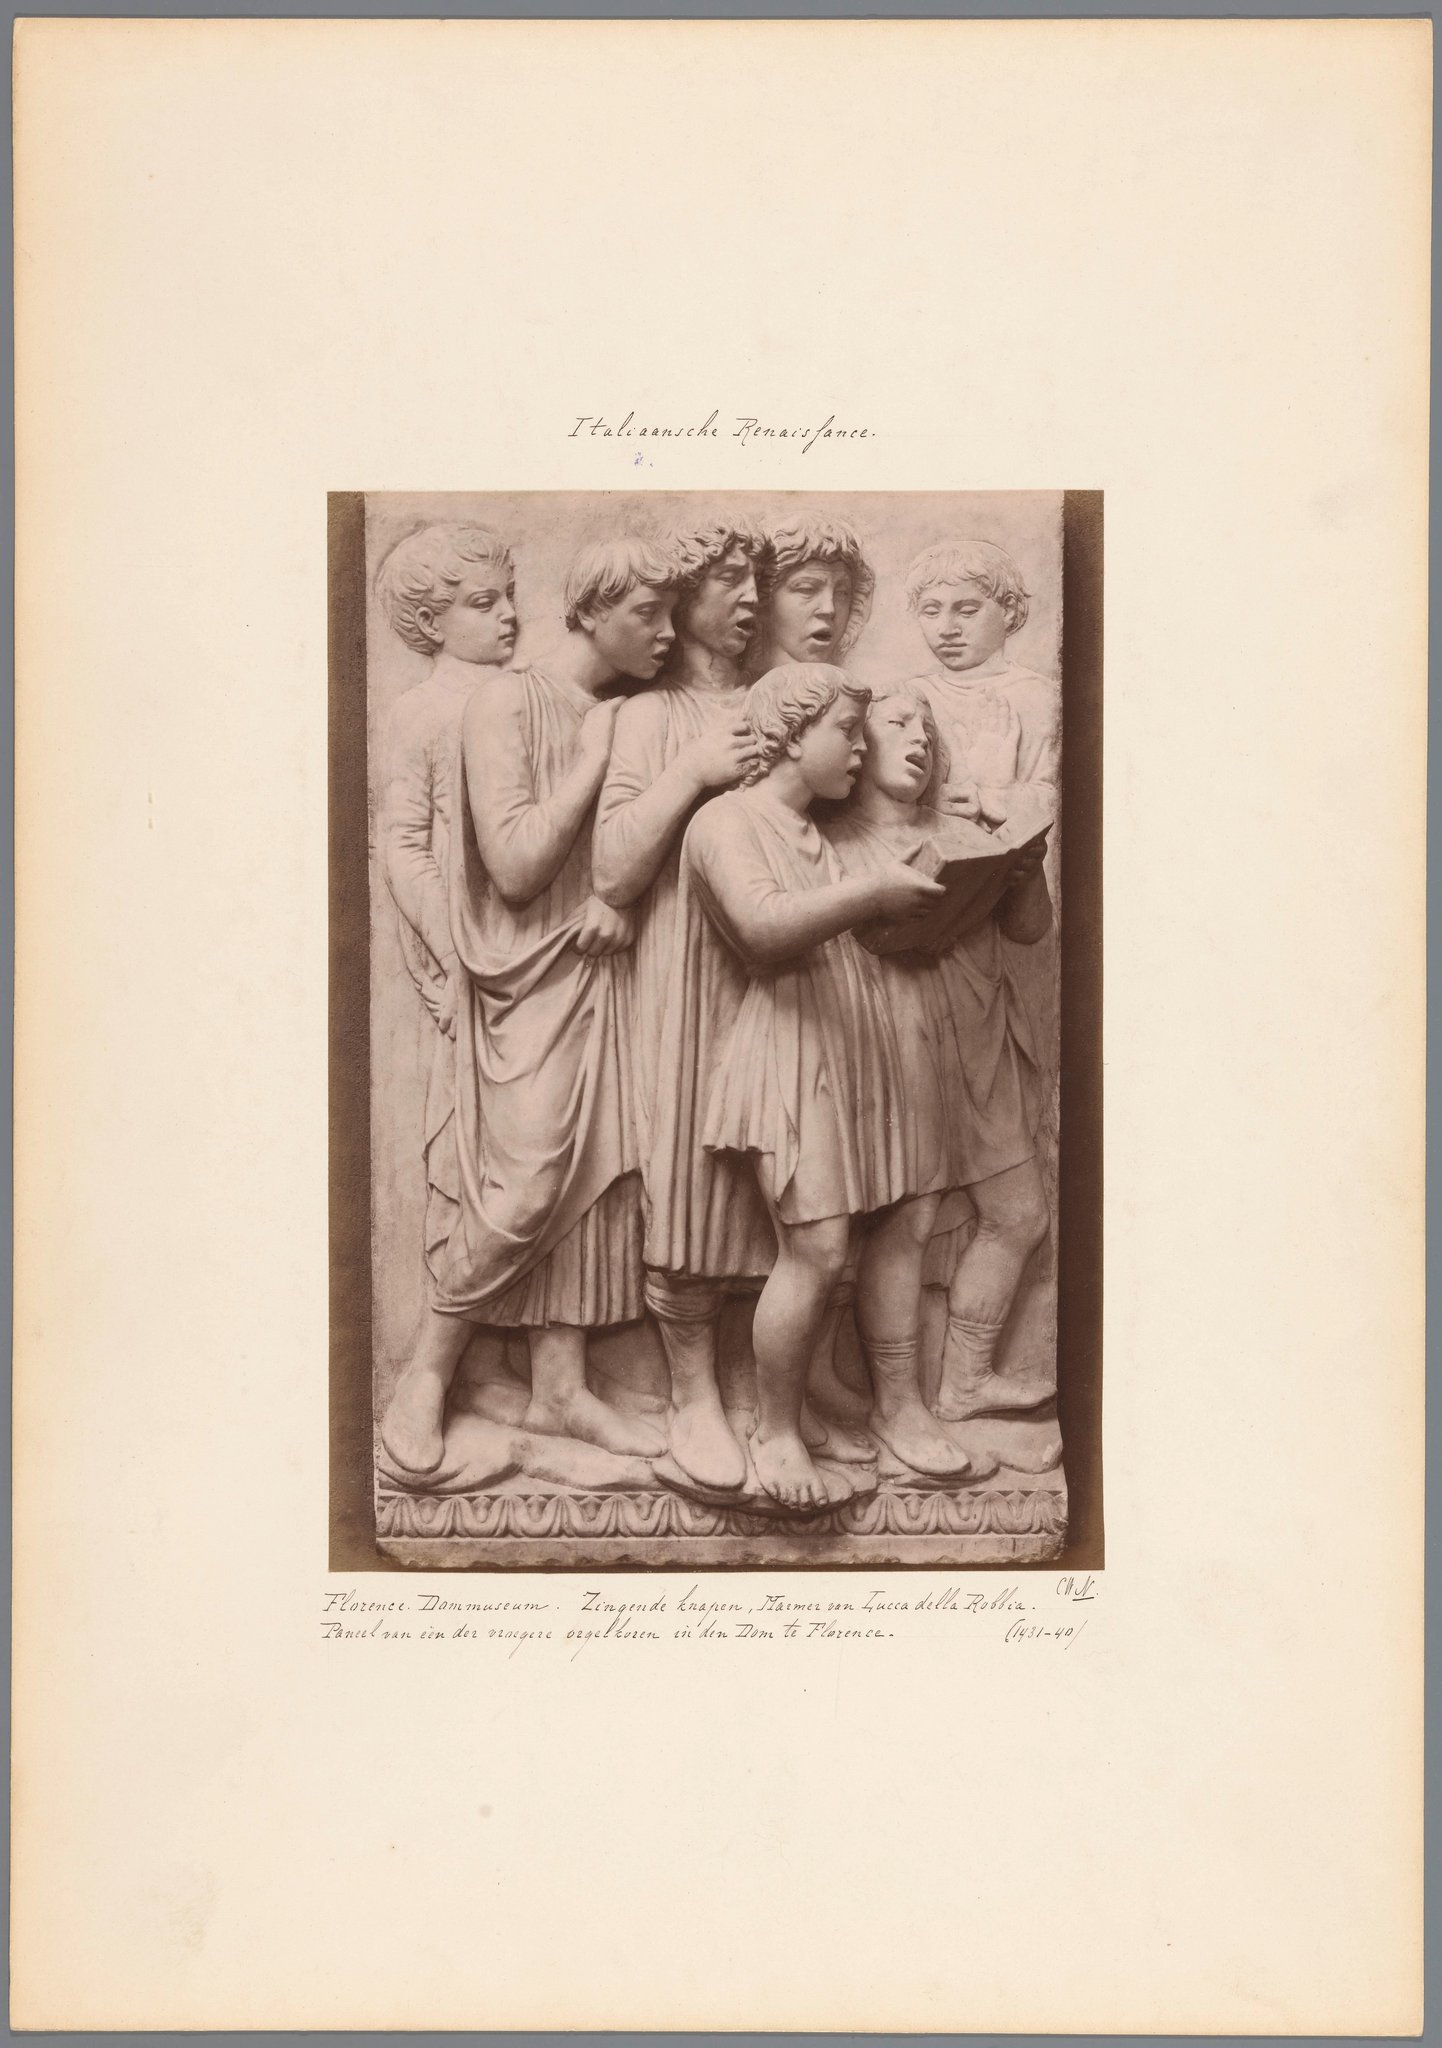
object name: photograph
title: Reliëf afkomstig van een koorkansel in de Dom te Florence door Luca della Robbia, voorstellend zingende kinderen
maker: Anonymous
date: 1875-1900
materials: cardboard, photographic support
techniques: albumen print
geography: europe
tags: children singing, sculpture (+ relief ~ sculpture), europe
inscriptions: collector's mark: ‘KUNSTNIJVERHEIDSCHOOL QUELLINUS AMSTERDAM FRANS HALSSTRAAT 14.’, collector's mark: ‘INSTITUUT VOOR KUNST-NIJVERHEIDSONDERWIJS GABRIËL METSUSTRAAT No. 16 AMSTERDAM’, inscription: ‘Italiaansche Renaissance.’, inscription: ‘CWN.’